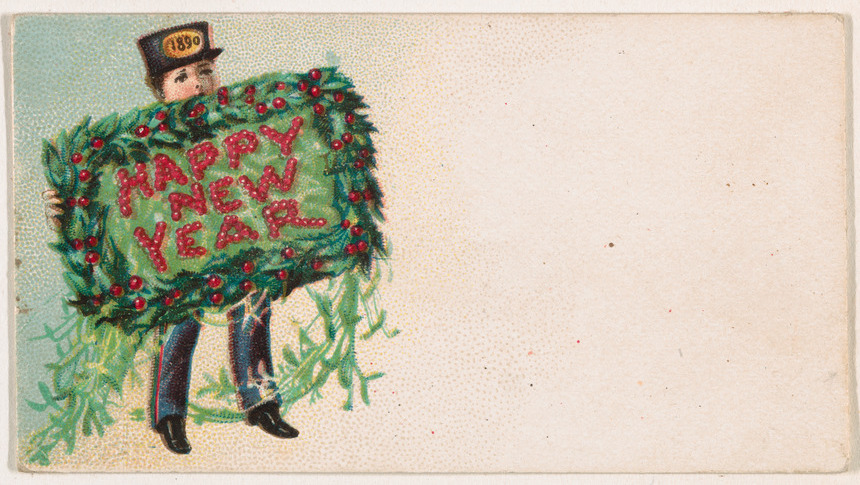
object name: print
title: Happy New Year, from the New Years 1890 series (N227) issued by Kinney Bros.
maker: kinney brothers tobacco company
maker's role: publisher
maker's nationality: american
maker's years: 1869-2011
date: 1889-1890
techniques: color lithograph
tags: boys